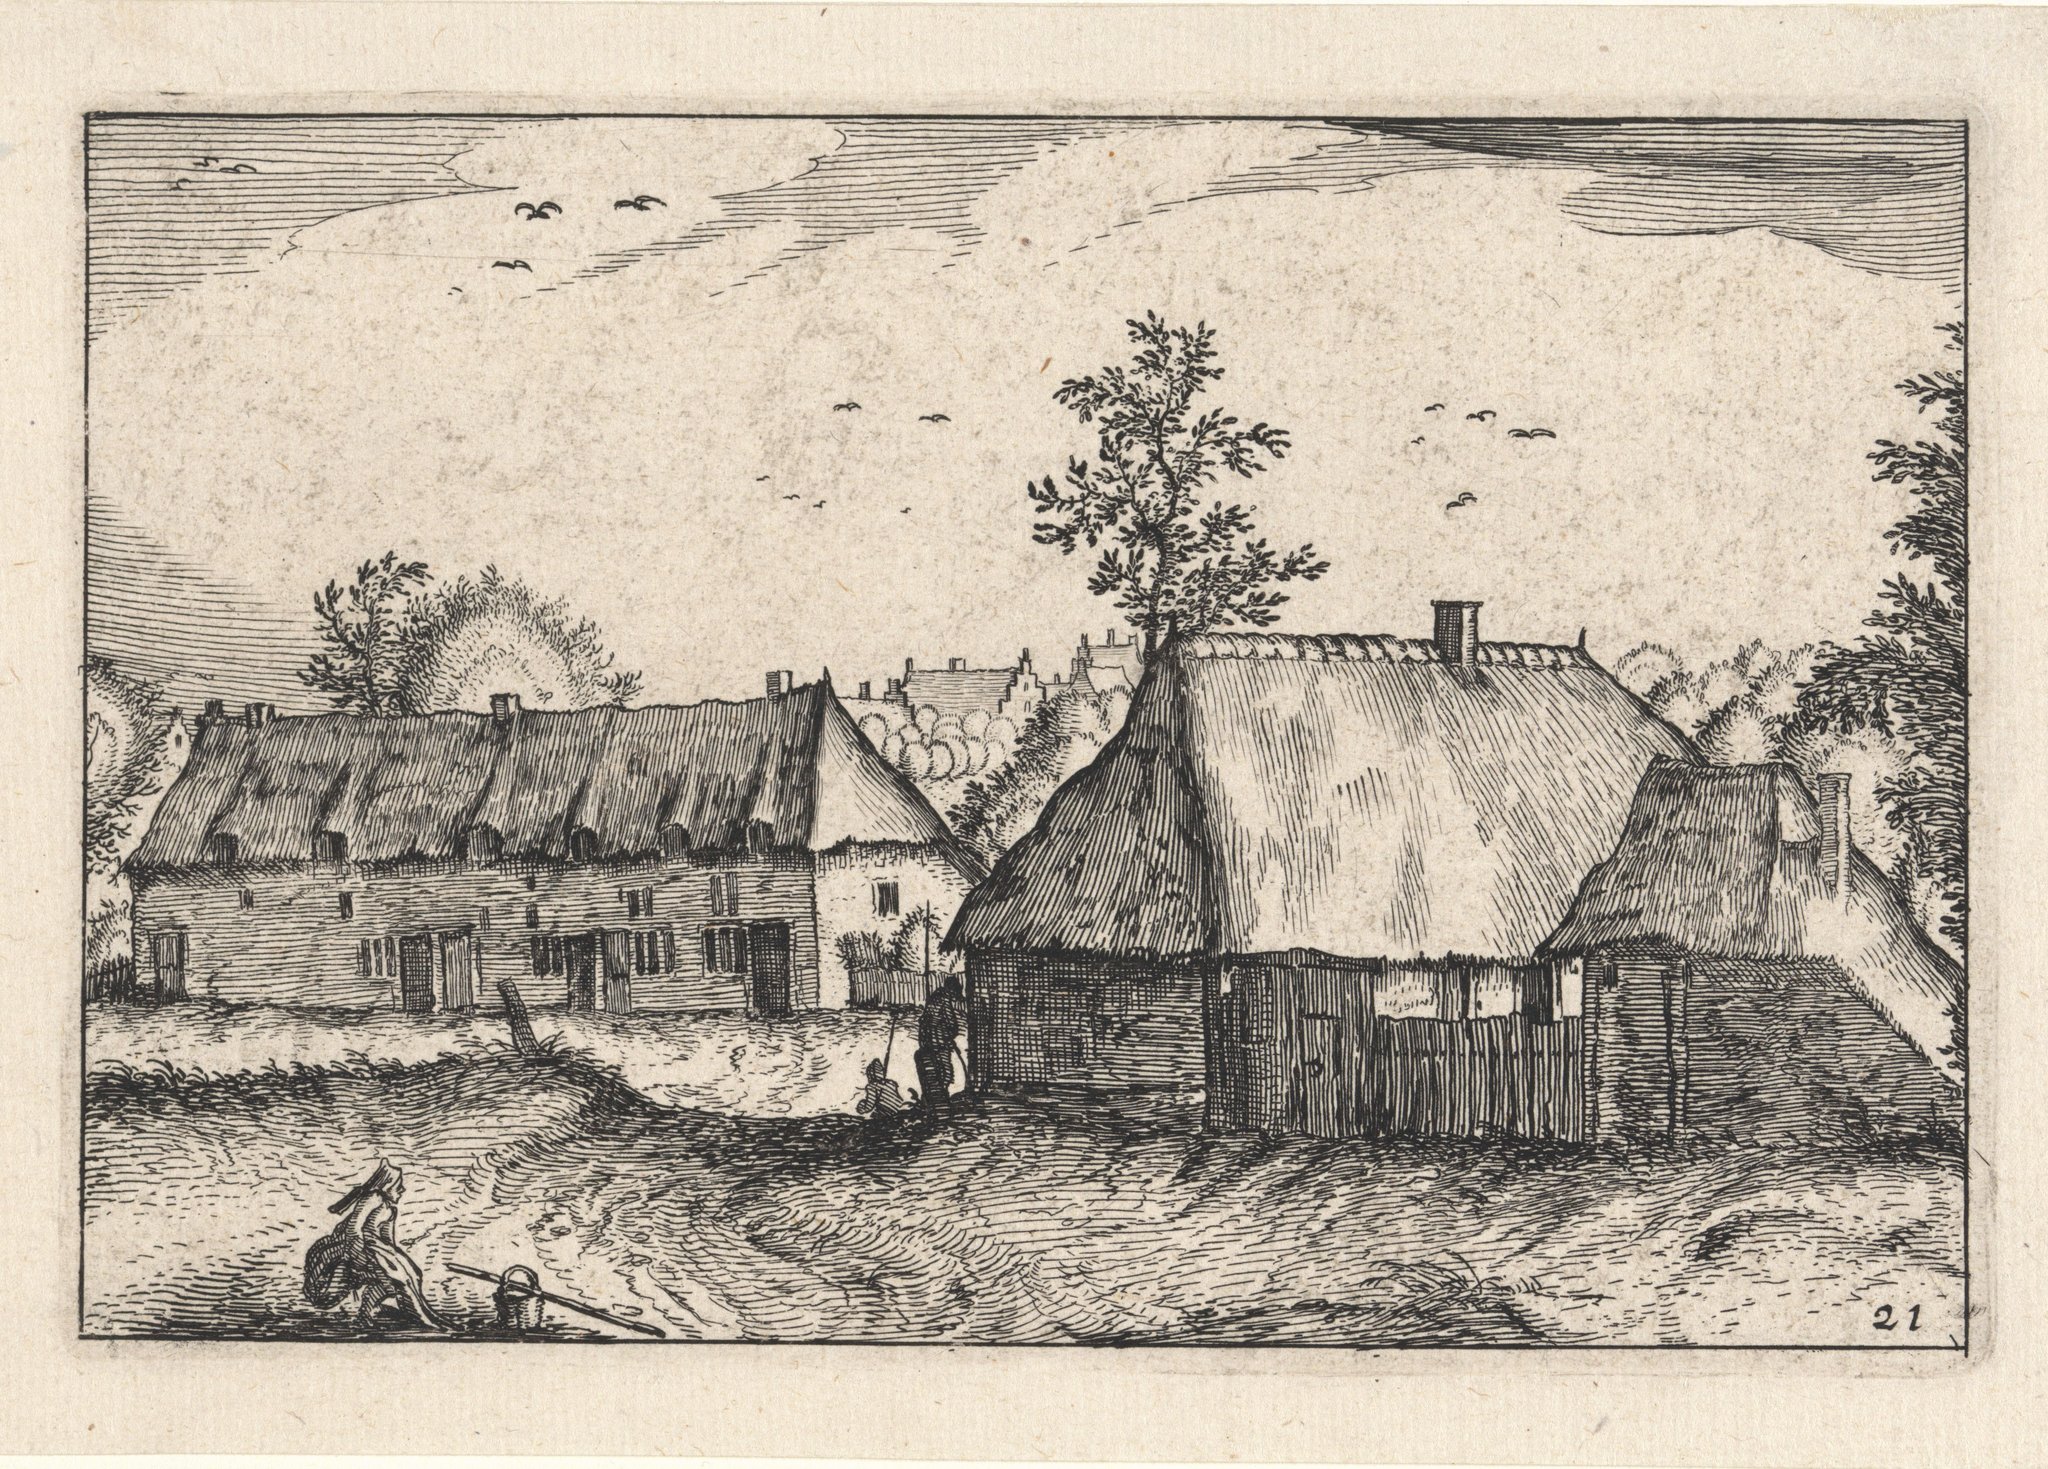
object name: print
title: Landschap met grote schuren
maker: claes jansz. visscher (ii)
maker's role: draughtsman, print maker, publisher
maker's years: 1586-1652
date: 1620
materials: paper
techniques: etching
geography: amsterdam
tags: farmers, shed, farm or solitary house in landscape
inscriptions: collector's mark: Lugt 240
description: In een landschap staan enkele grote schuren. Op de voorgrond zit een vrouw met een emmer. Op de achtergrond zijn enige stenen huizen met trapgevels te zien.